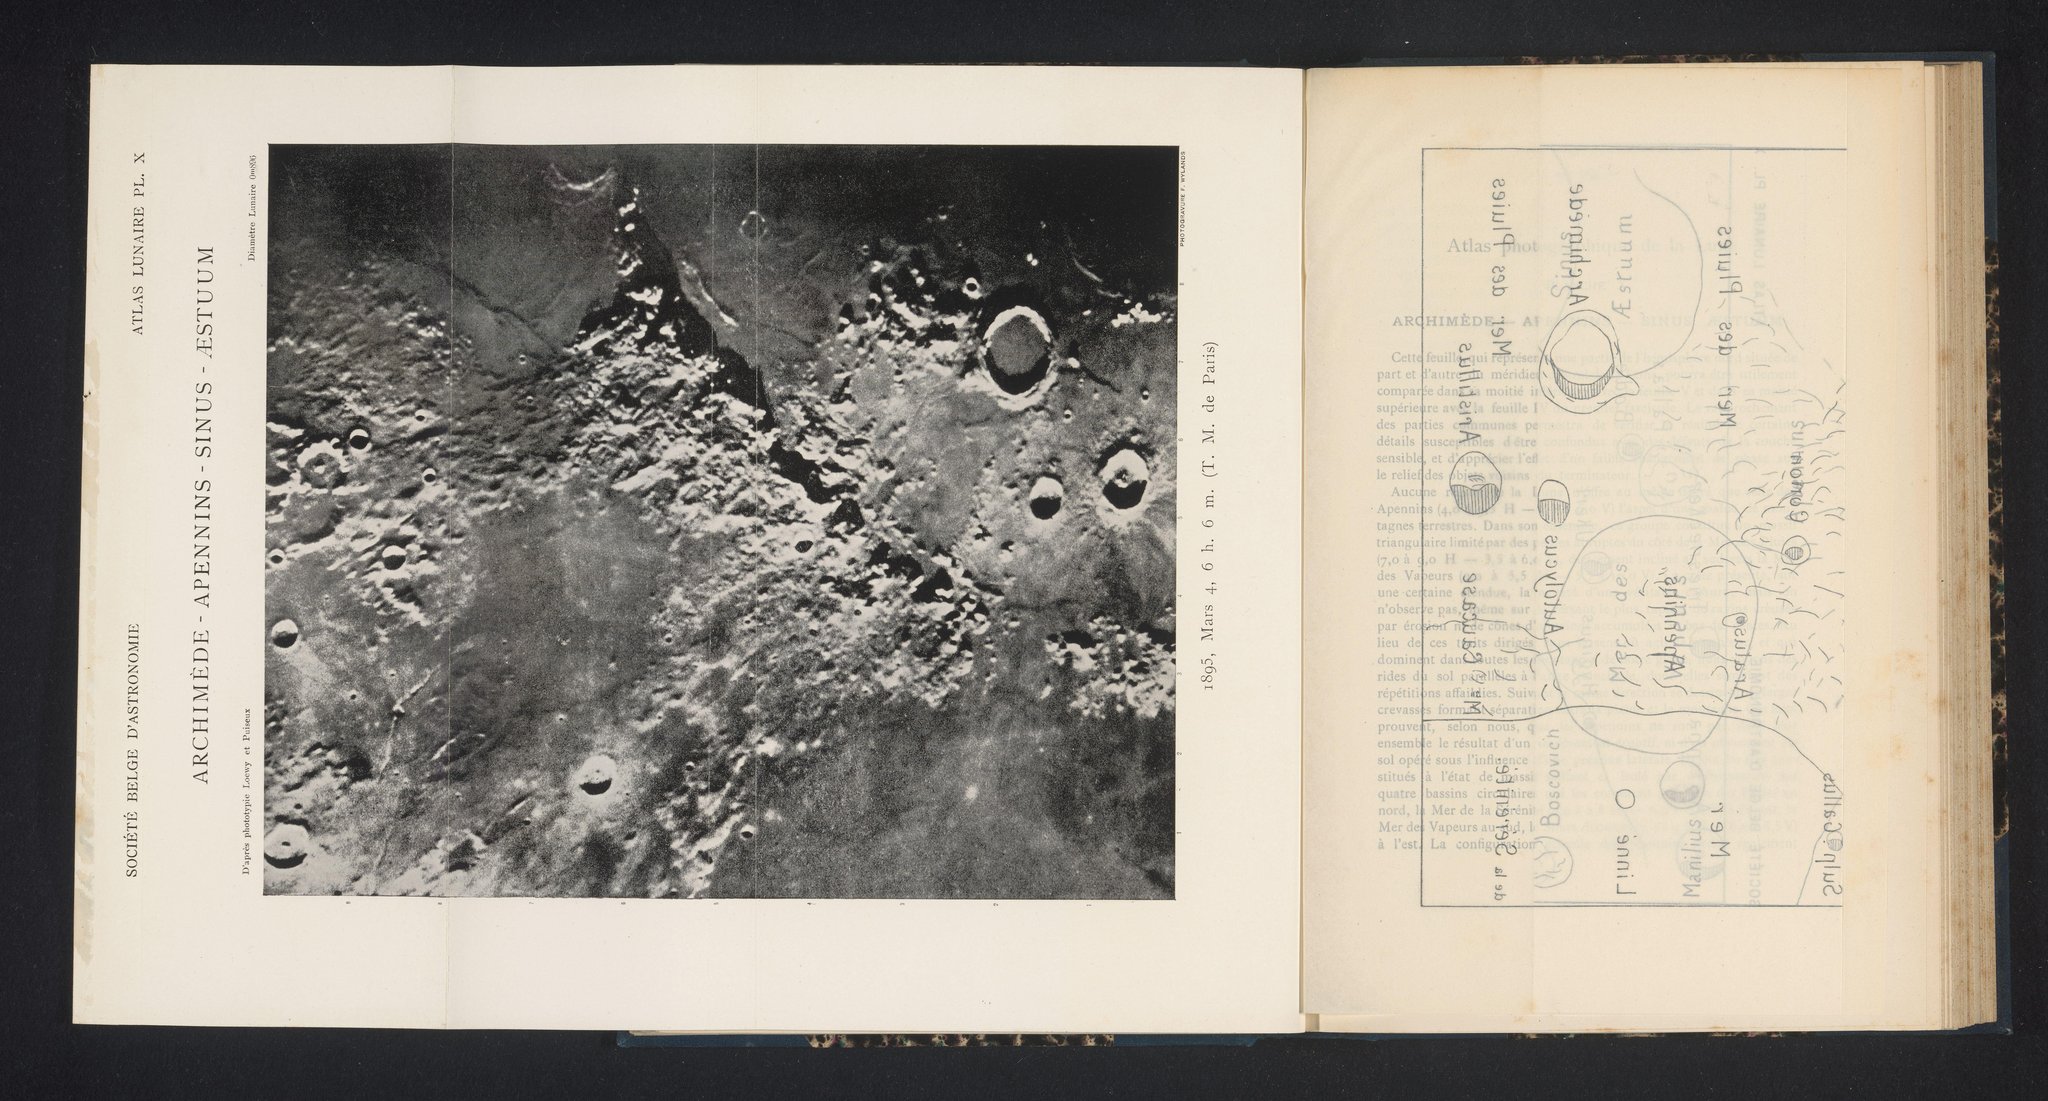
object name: page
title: Archiméde - Apennins - Sinus - Aestuum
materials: paper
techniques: autotype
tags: surface of the moon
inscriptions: inscription: ‘Société Belge D'Astronomie Atlas Lunaire Pl. X/ 1895, Mars 4, 6 h. 6m. (T. M. de Paris)’